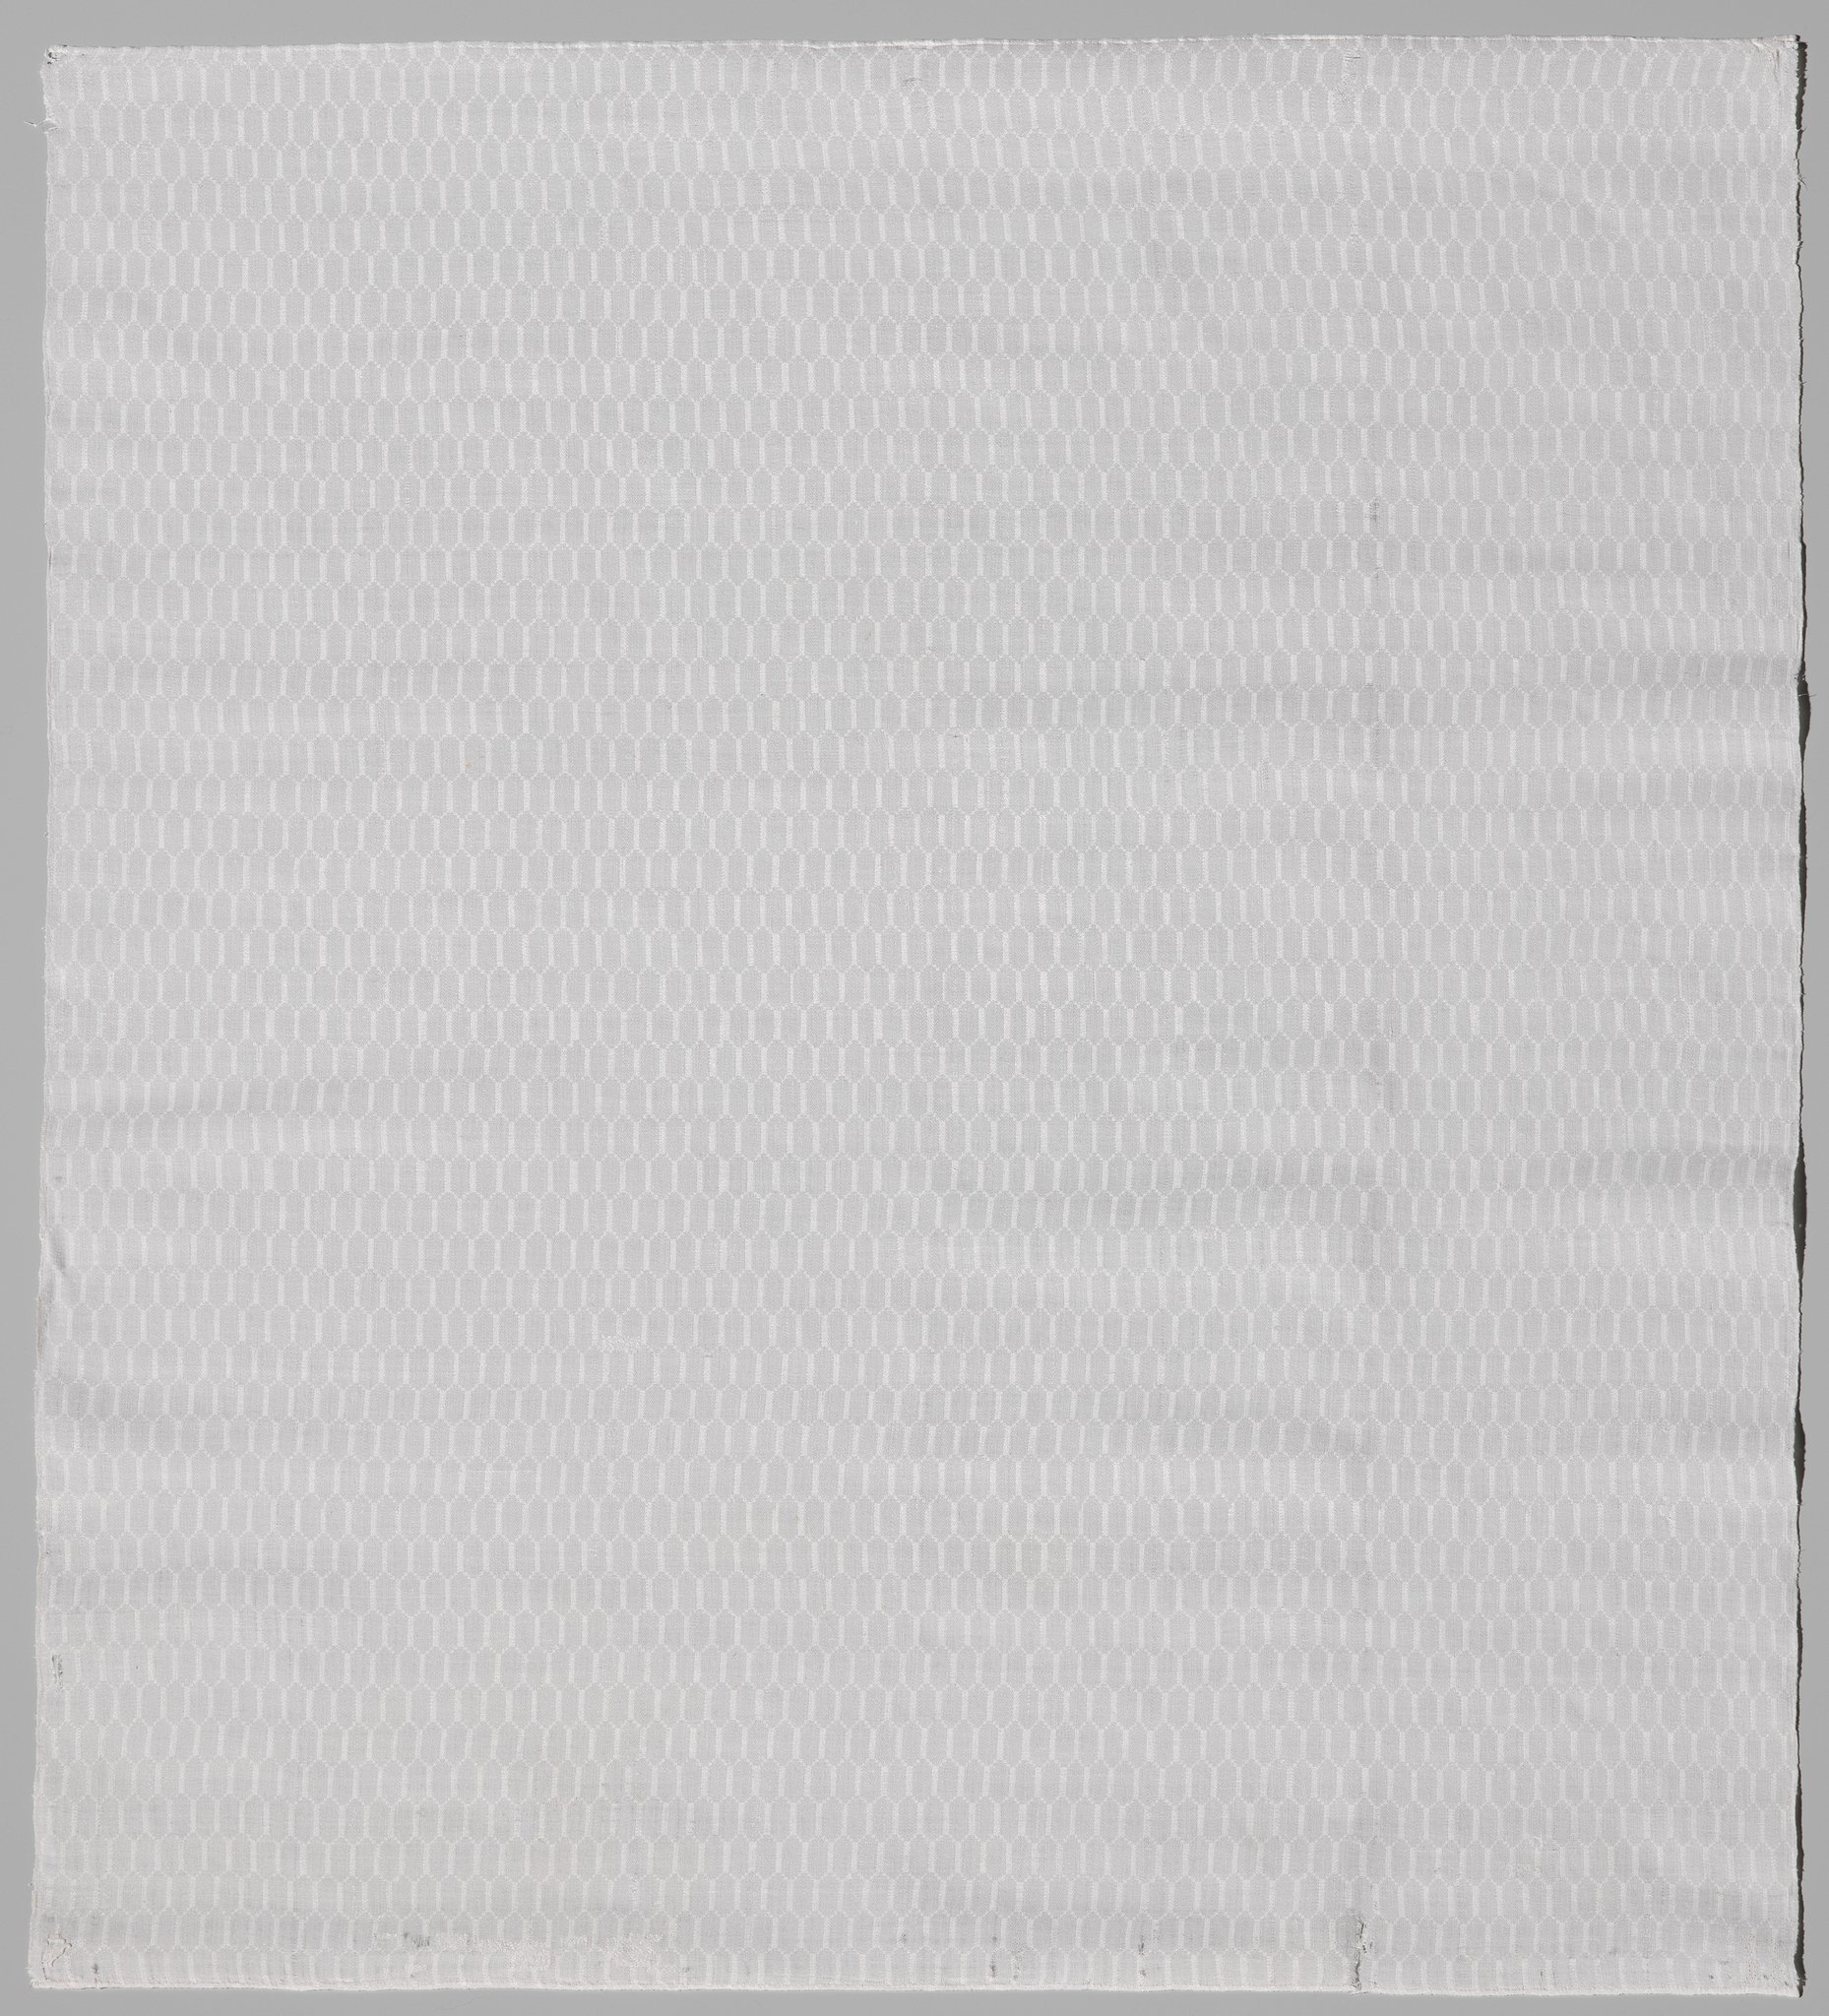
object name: napkin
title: Servet van linnendamast met schakelpatroon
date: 1850-1899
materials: linen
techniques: damask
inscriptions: : ‘O N 12’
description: Servet van linnendamast met schakelpatroon, gemerkt met bindgatletters O N 12.